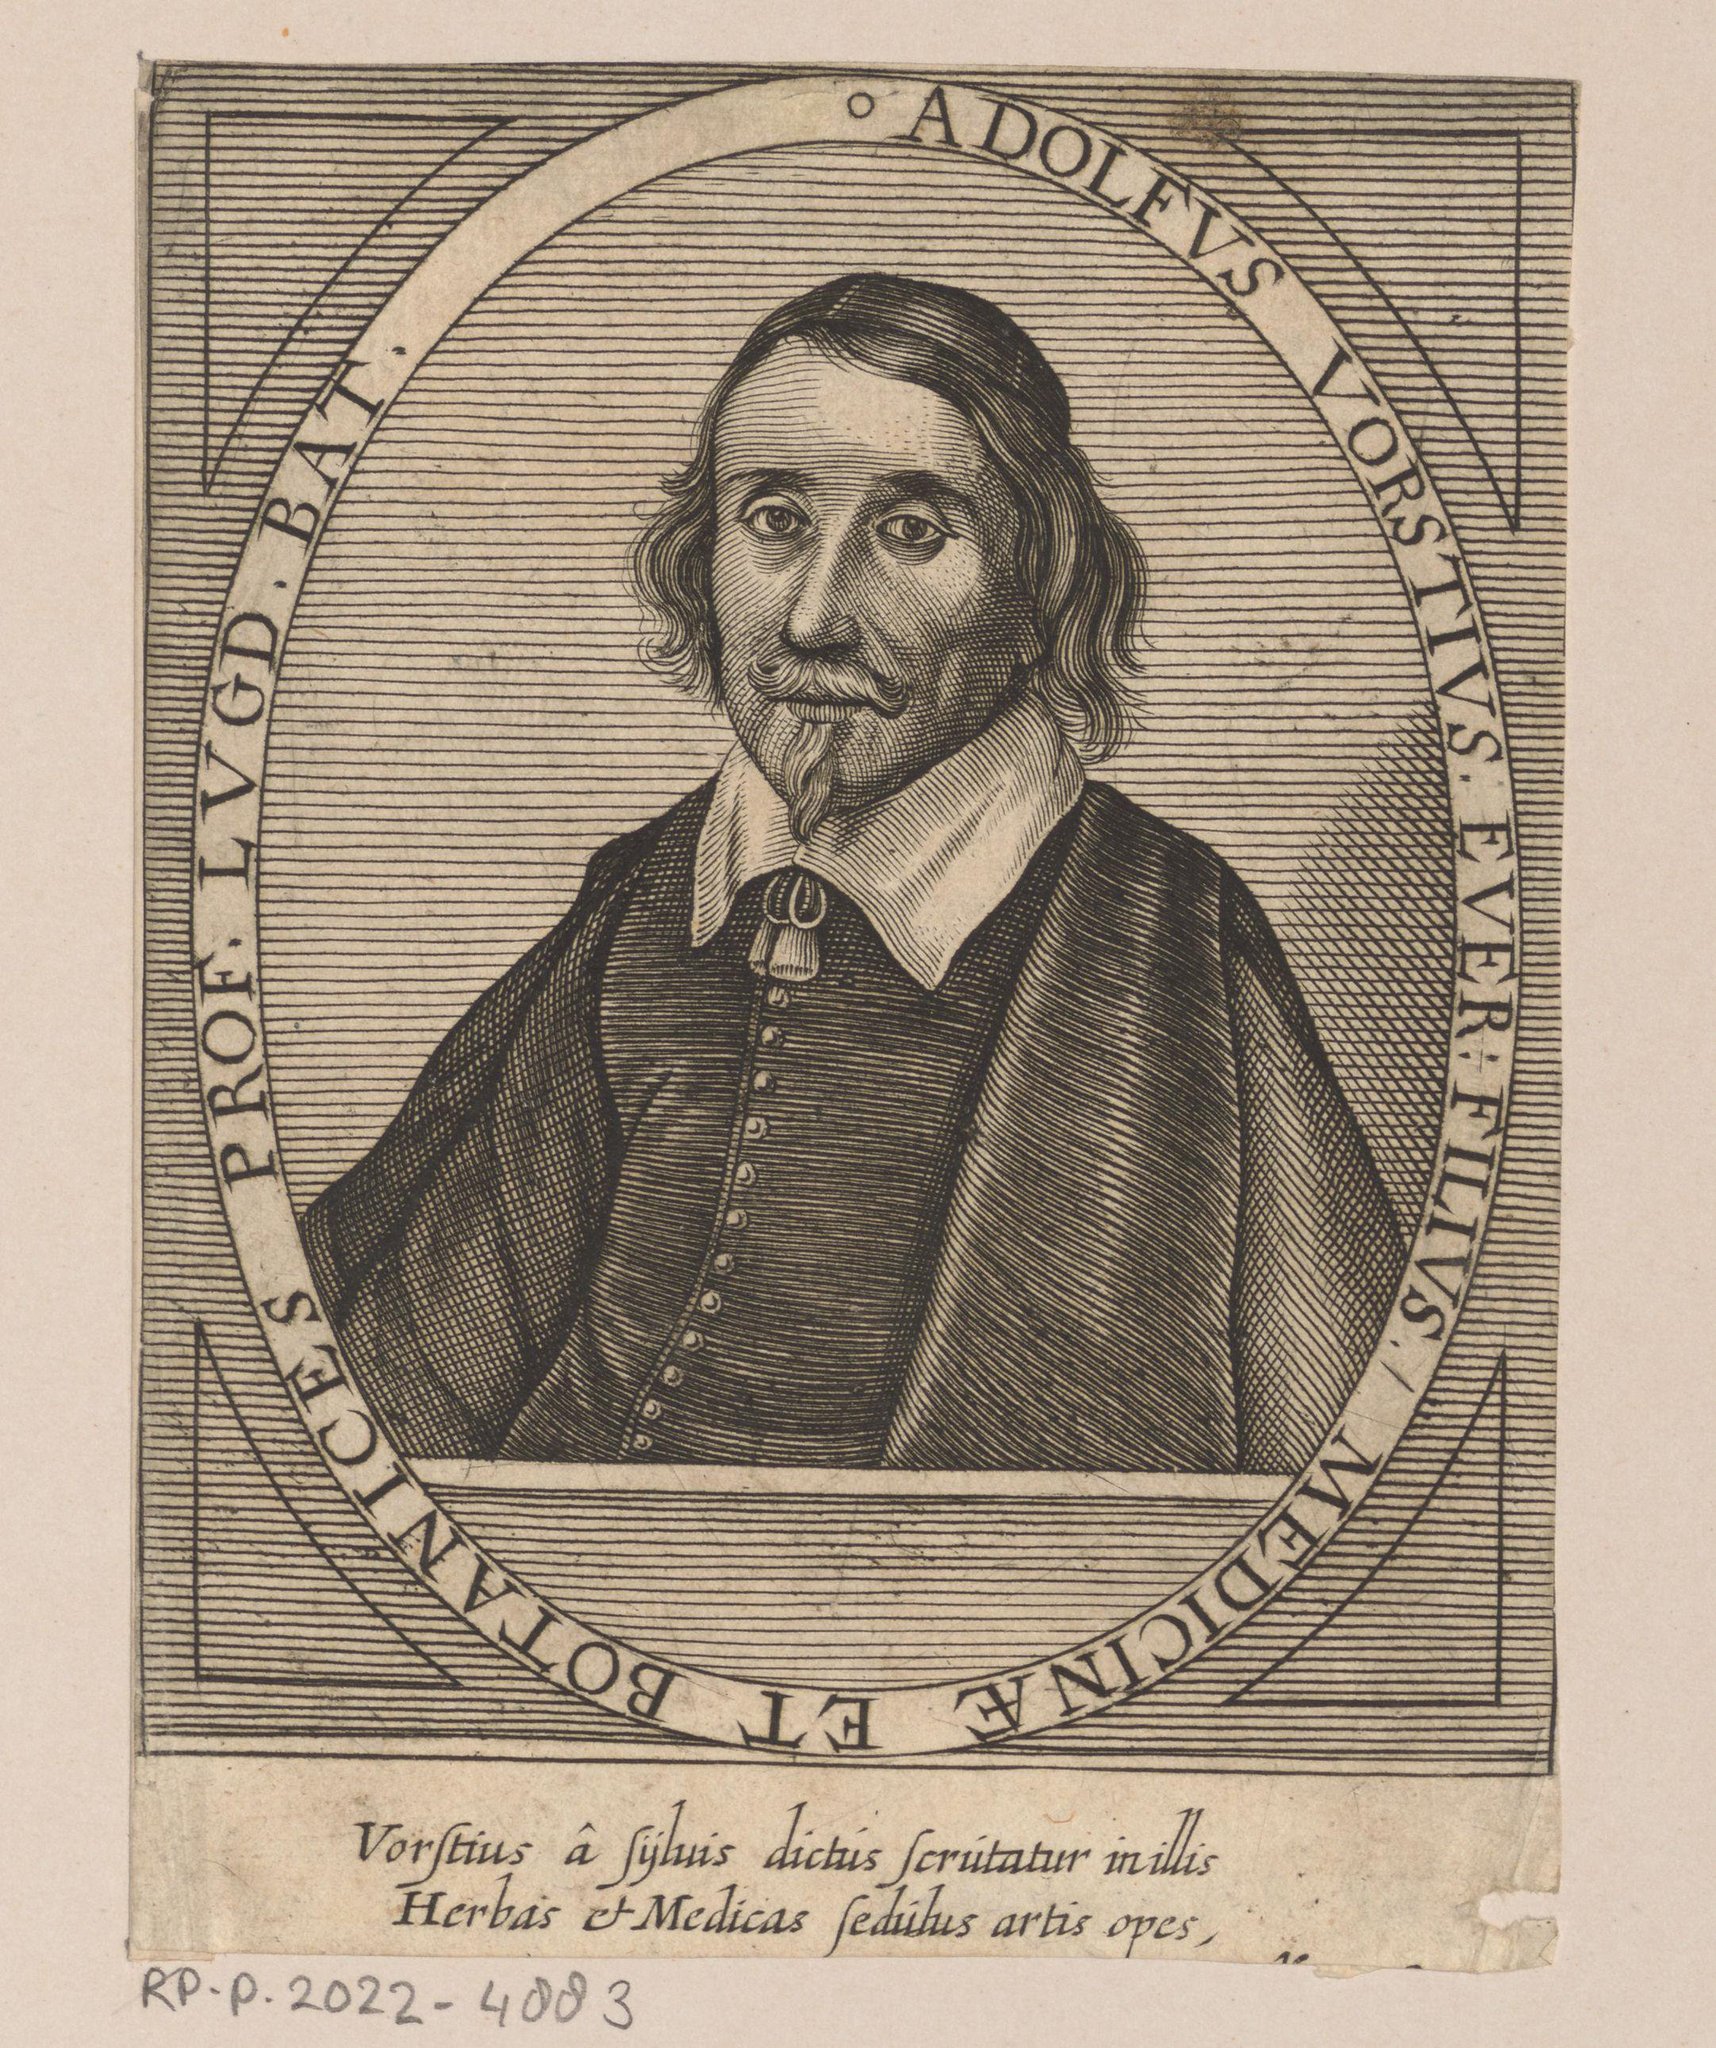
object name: print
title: Bibliotheca chalcographica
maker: matthias van sommer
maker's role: draughtsman, print maker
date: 1643-1654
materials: paper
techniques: engraving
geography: germany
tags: delft, leiden, scholar, philosopher, historical persons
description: Latere staat gebruikt in: Boissard, Jean Jacques. Bibliotheca chalcographica (...) Frankfurt am Main: Johannes Ammon, 1654, dl. 9.